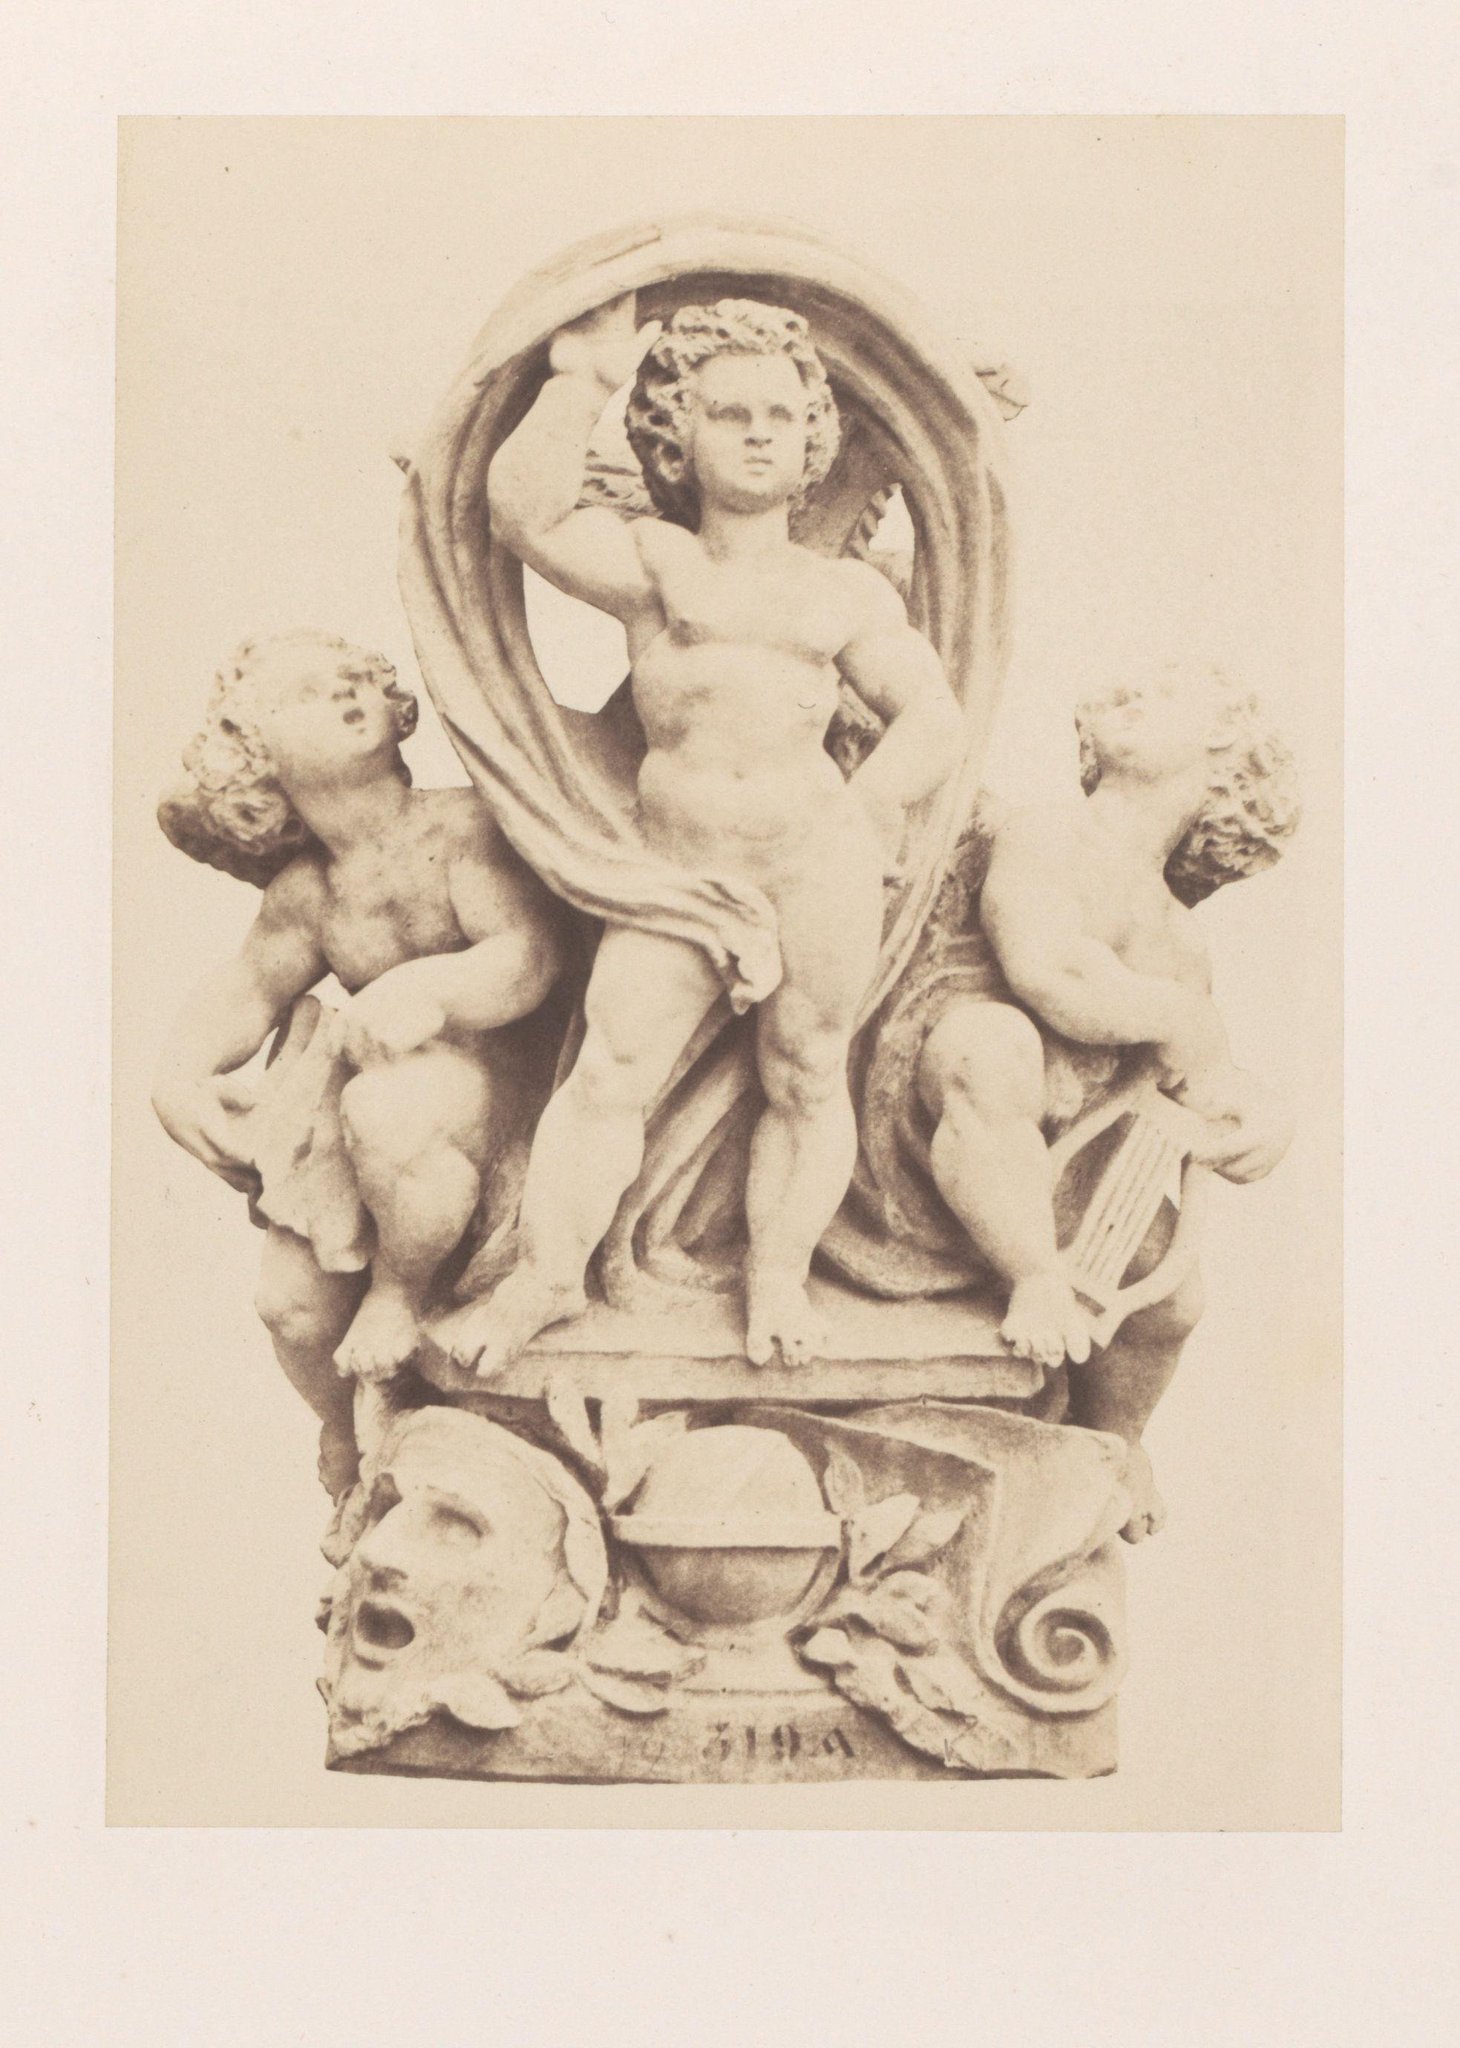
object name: photograph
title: Gipsmodel voor beeldhouwwerk op het Palais du Louvre: "Les Arts" door Auguste Préault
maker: édouard denis baldus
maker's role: fotograaf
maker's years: 1813-1889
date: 1855-1857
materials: paper, photographic support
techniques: salted paper print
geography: paris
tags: piece of sculpture, reproduction of a piece of sculpture, permanent exhibition, museum, paris, tuileries palace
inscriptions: number: ‘319A’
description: Onderdeel van Réunion des Tuileries au Louvre 1852-1857, album 4.